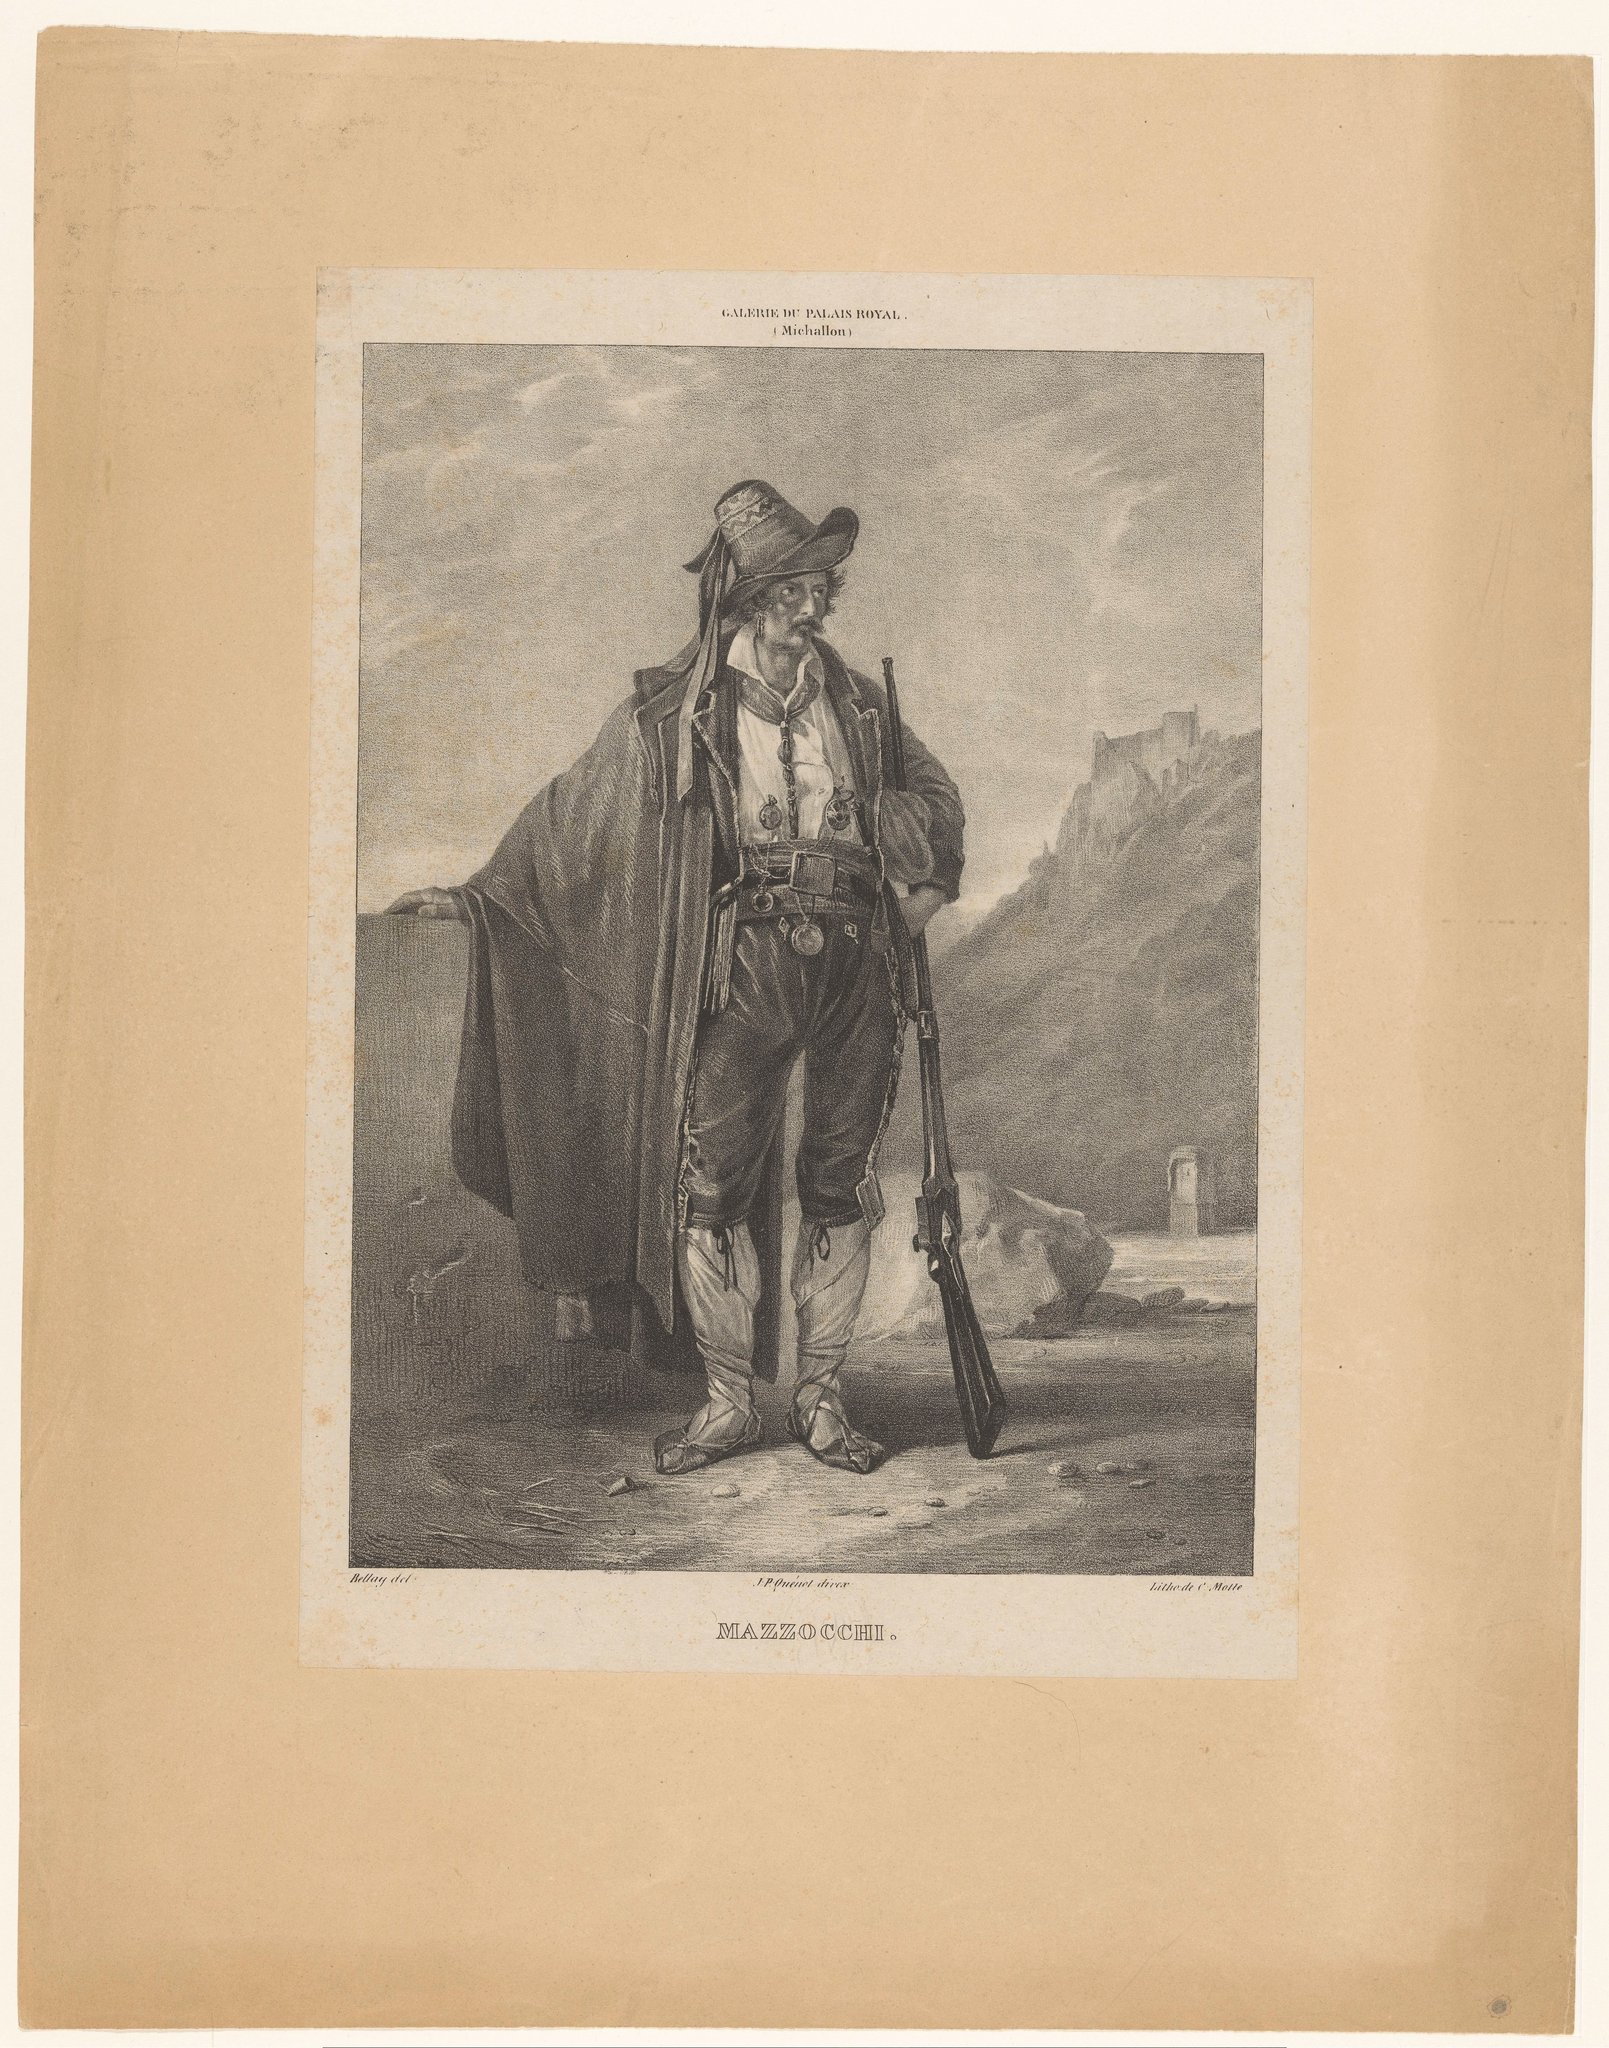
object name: print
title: Mazzocchi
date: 1824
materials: paper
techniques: lithograph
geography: paris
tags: historical persons, robber, firearms: rifle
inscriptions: collector's mark: Lugt 2228a